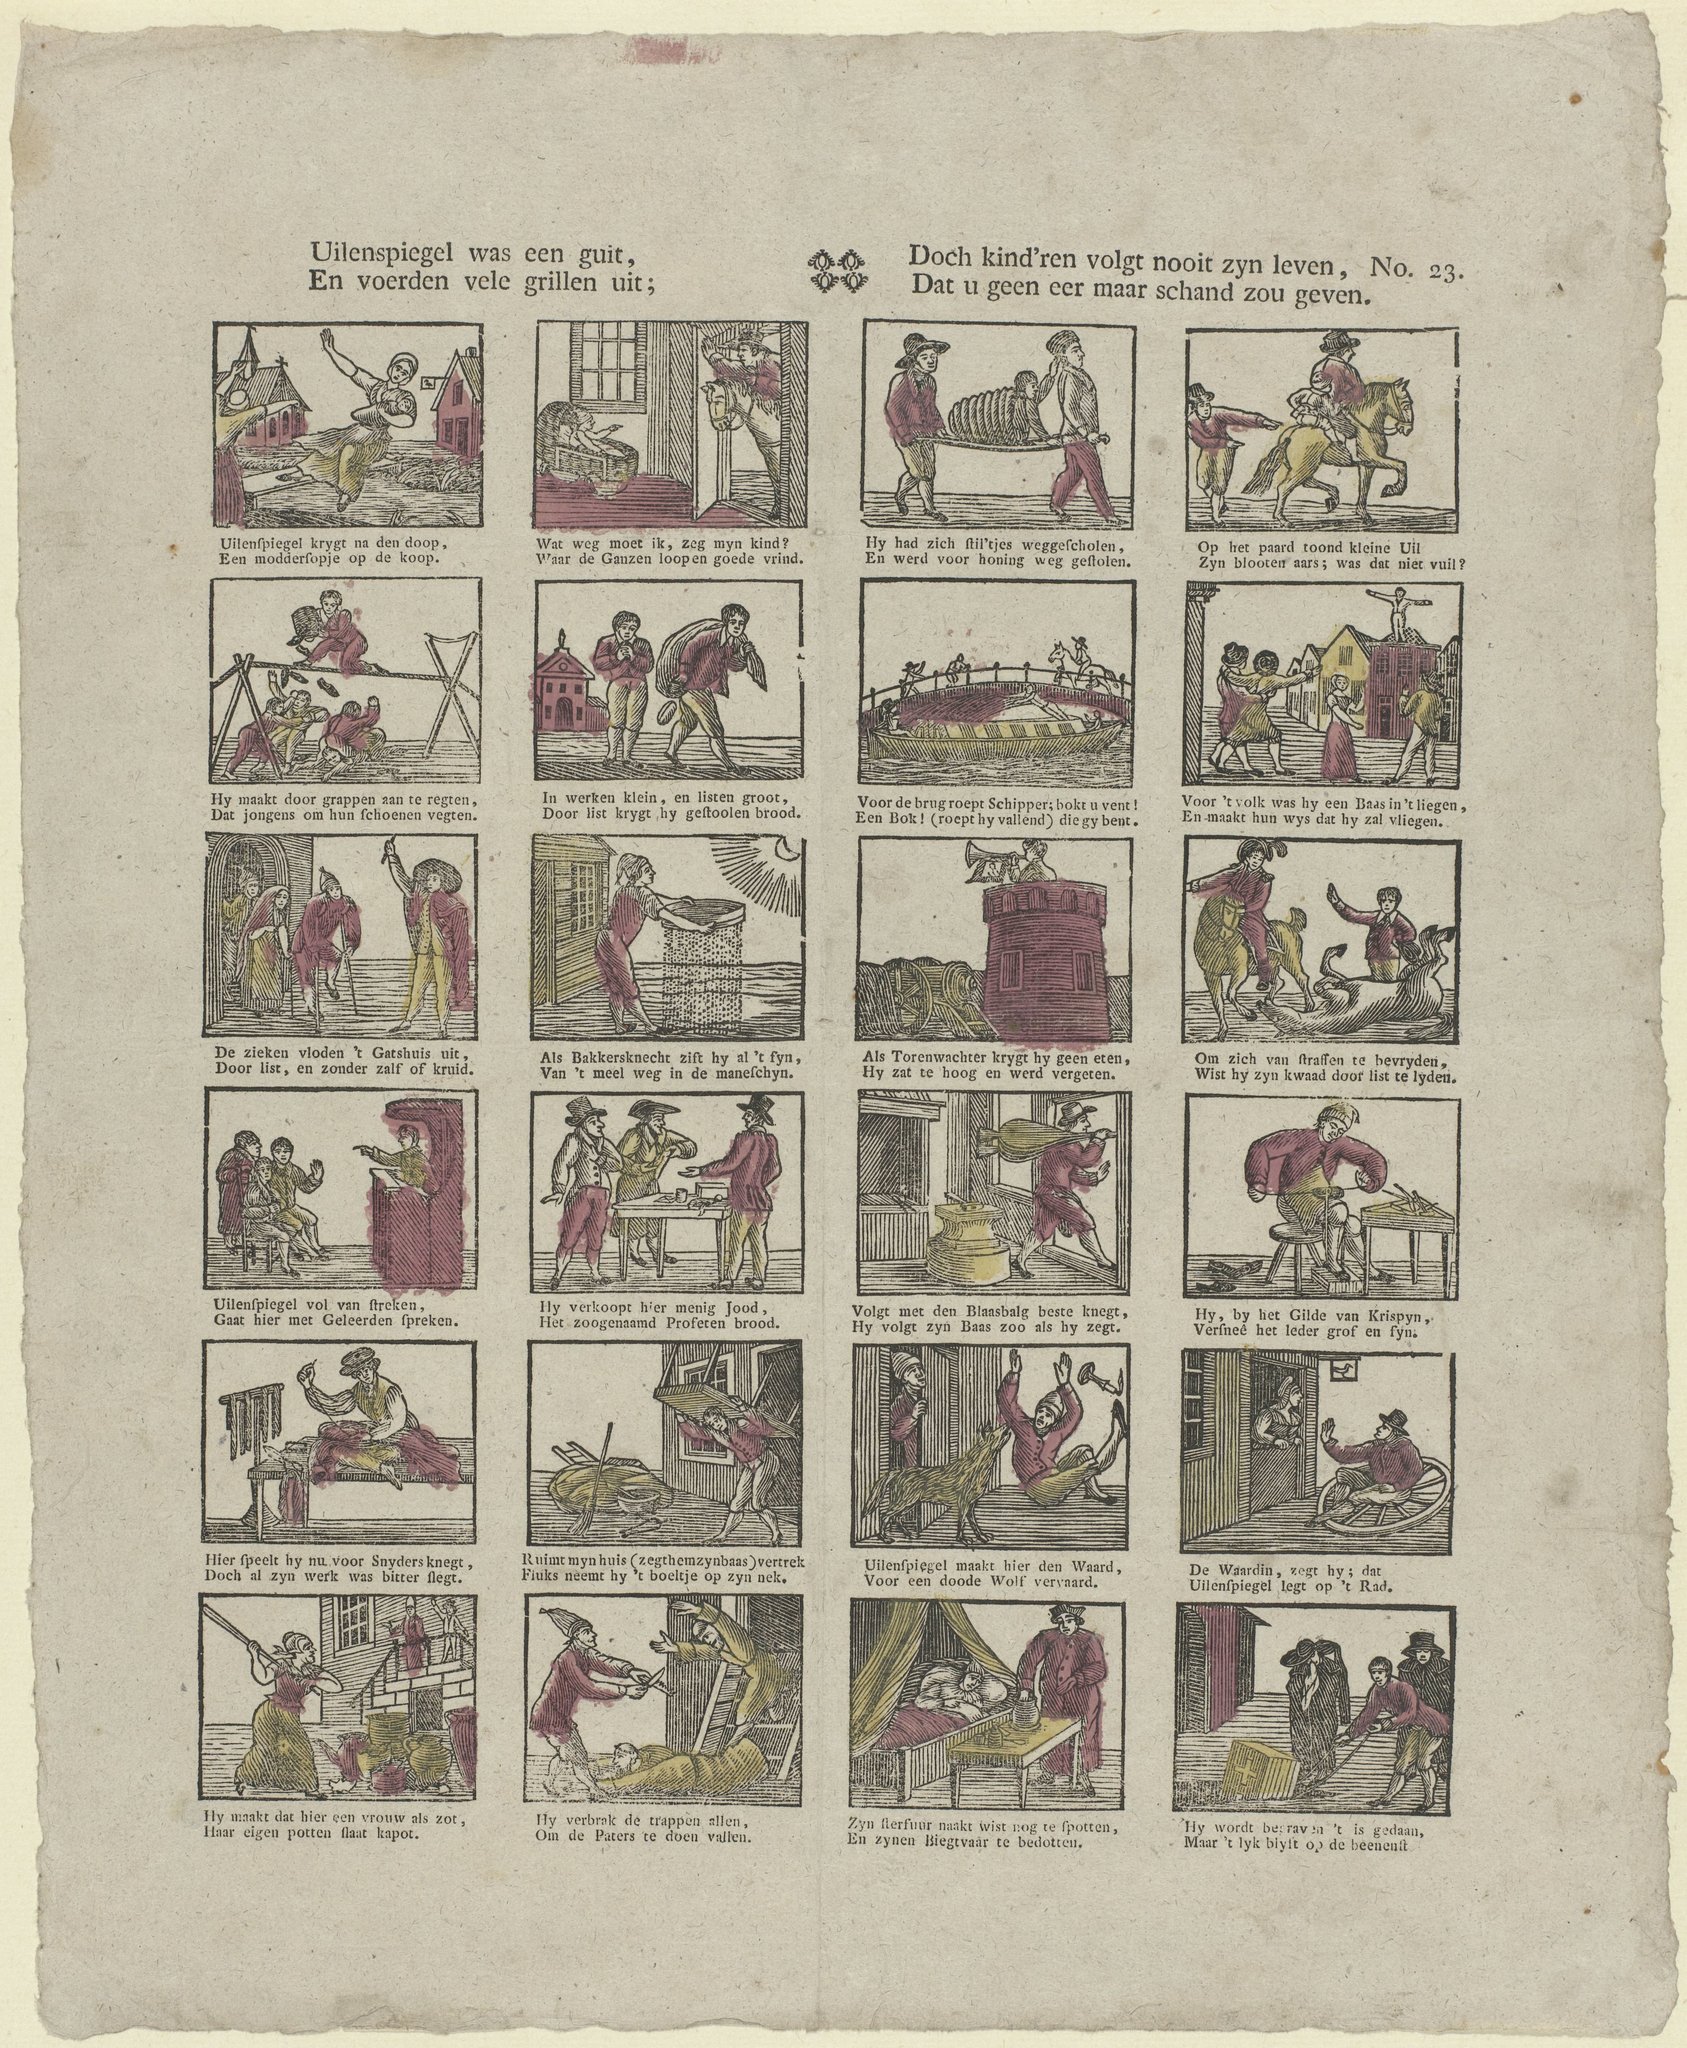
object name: popular print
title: Uilenspiegel was een guit, / En voerden vele grillen uit; / Doch kind'ren volgt nooit zyn leven, / Dat u geen eer maar schand zou geven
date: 1820-1838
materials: paper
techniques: colour, letterpress printing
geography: rotterdam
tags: eulenspiegel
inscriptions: collector's mark: Lugt 2760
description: Blad met 24 voorstellingen over het leven van Tijl Uilenspiegel. Onder elke afbeelding een tweeregelig vers. Genummerd rechtsboven: No. 23.